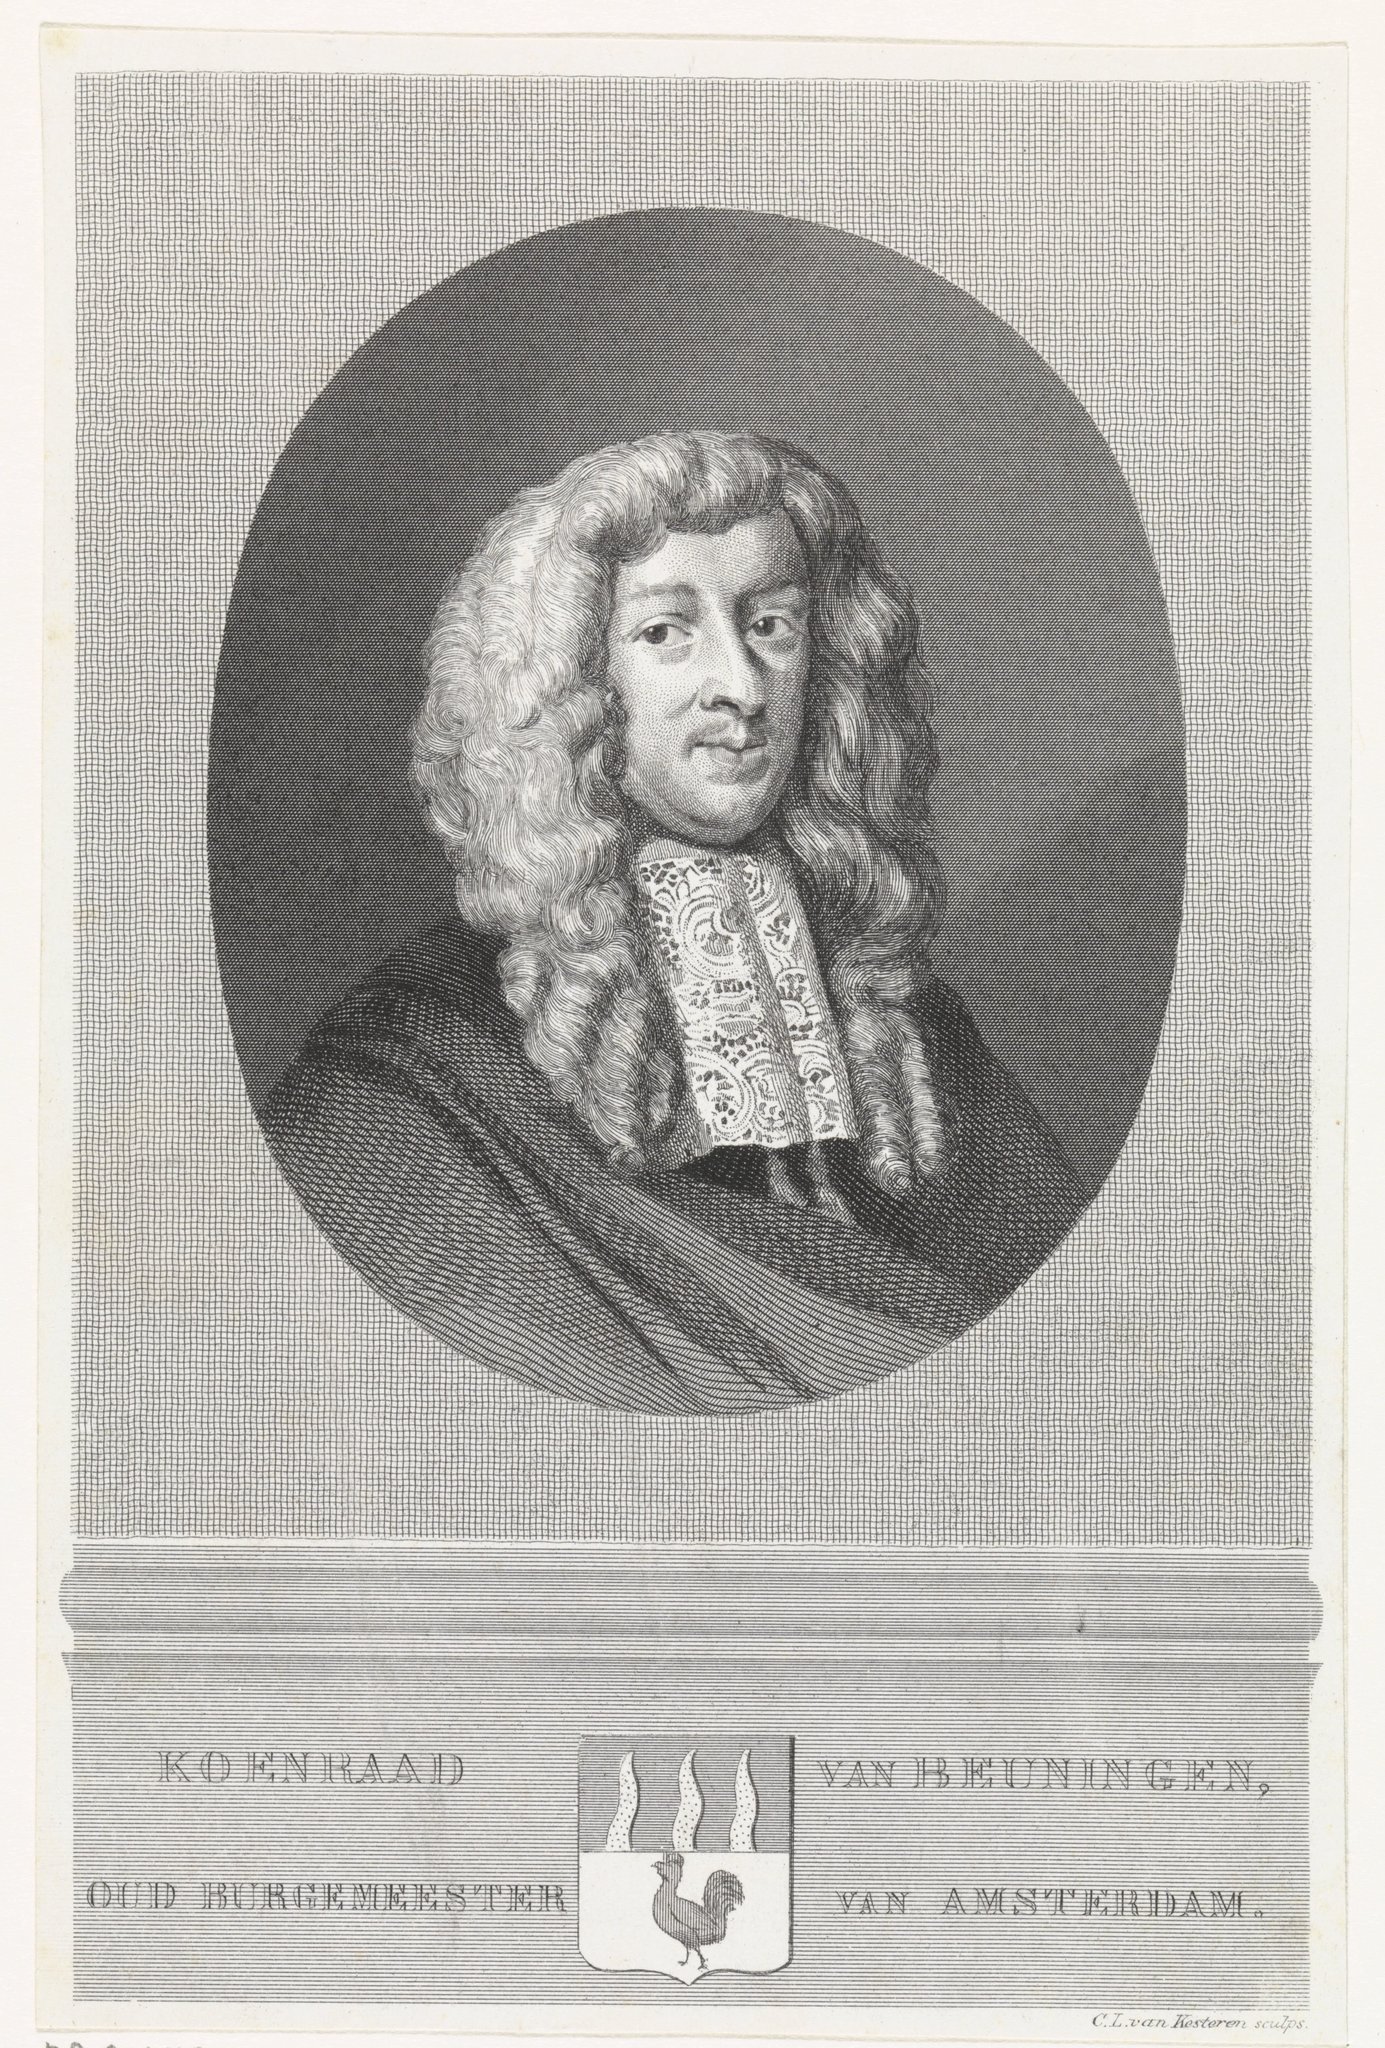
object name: print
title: Portret van Koenraad van Beuningen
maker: christiaan lodewijk van kesteren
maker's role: print maker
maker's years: 1832-1897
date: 1842-1897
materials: paper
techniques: engraving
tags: mayor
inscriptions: collector's mark: Lugt 2228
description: Portretbuste in ovaal naar rechts van Koenraad van Beuningen, burgemeester van Amsterdam, staatsman en diplomaat. Onder het portret zijn naam en zijn familiewapen.